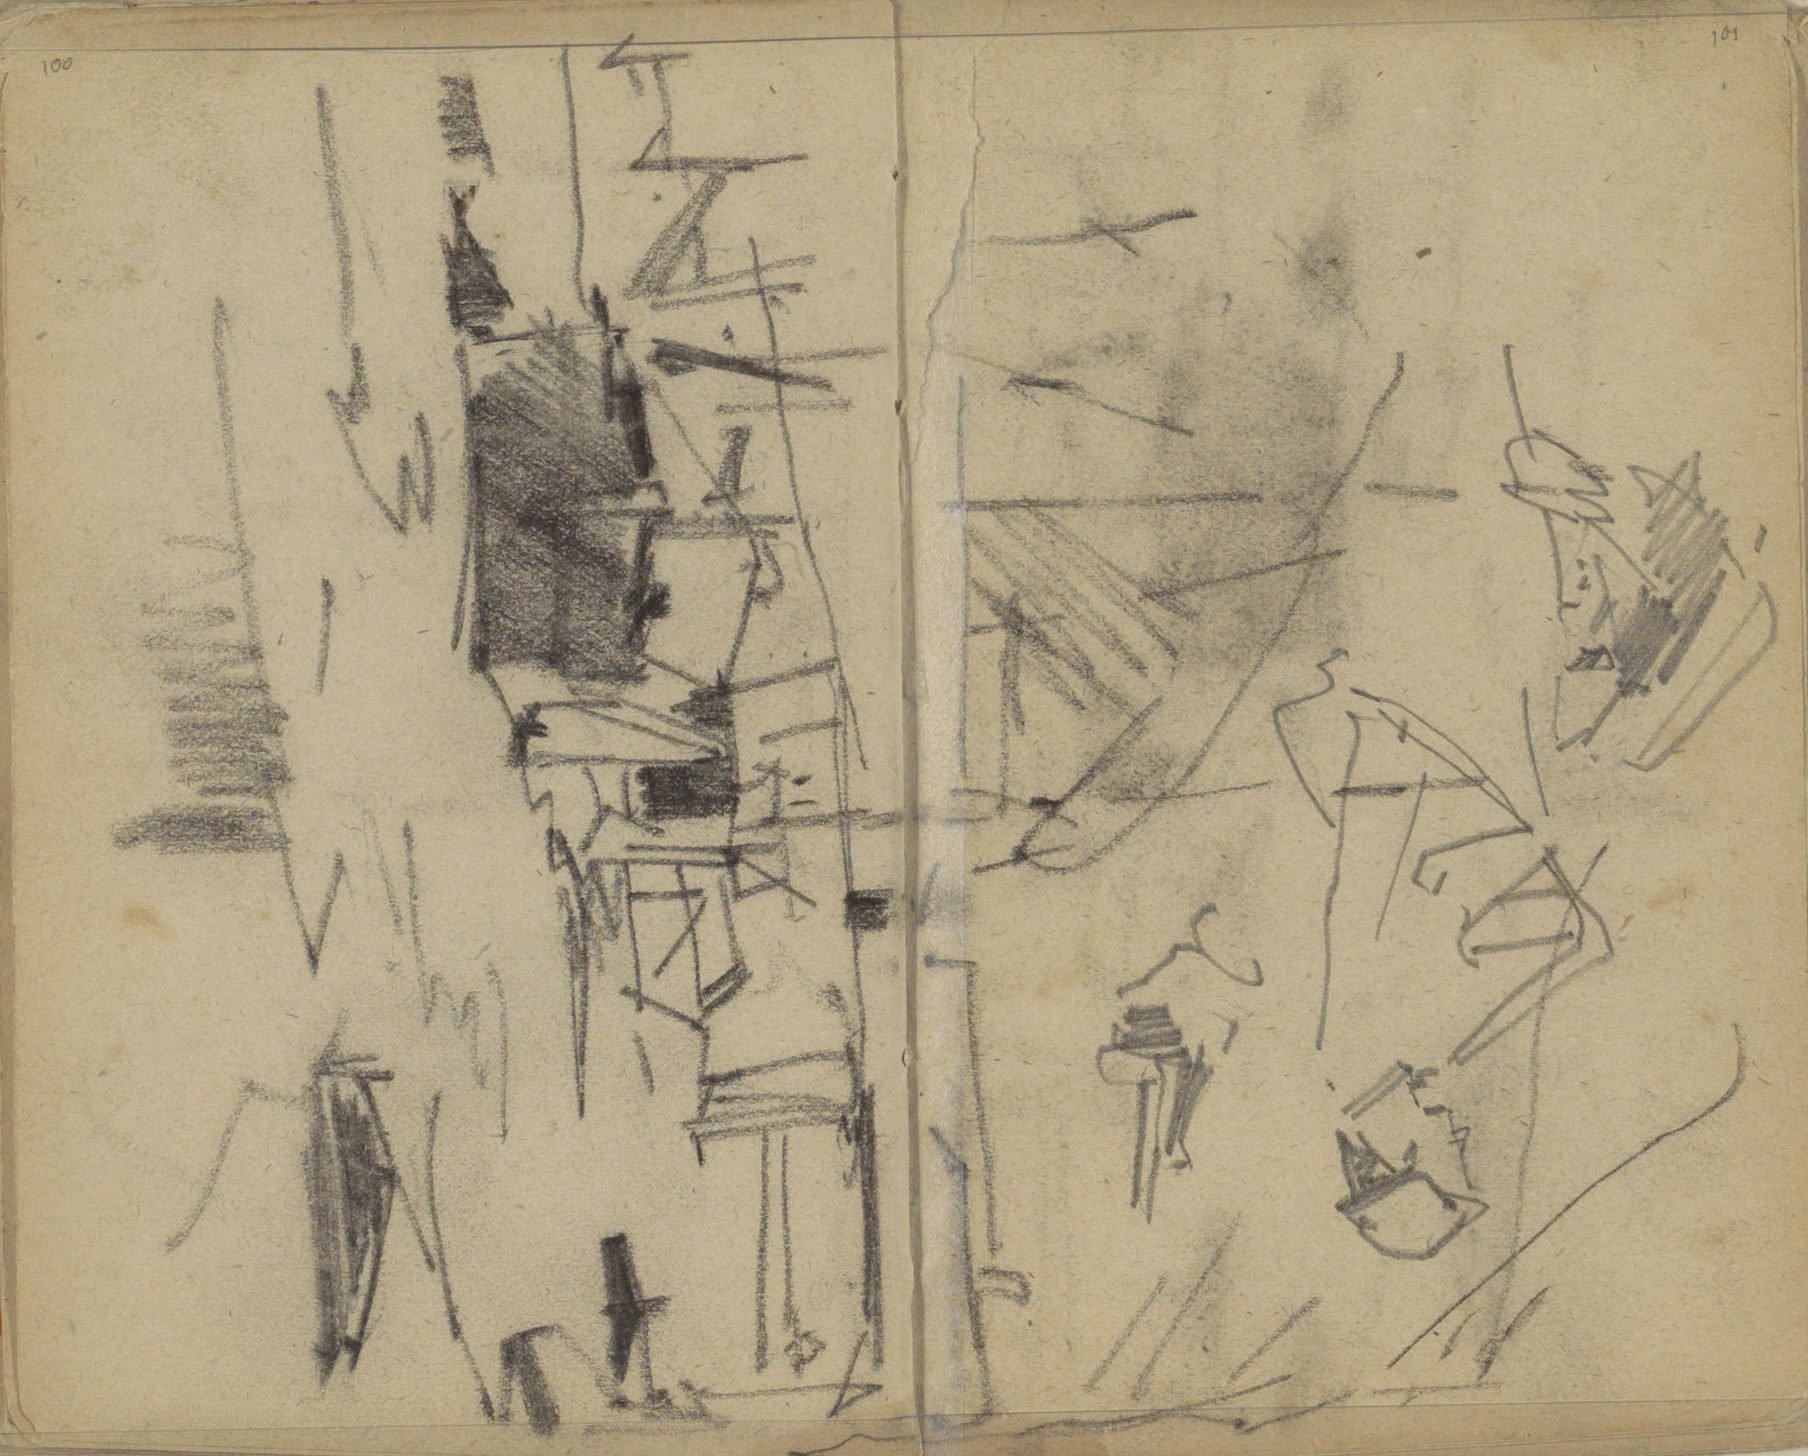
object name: sketchbook leaf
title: Studie, mogelijk van bouwmateriaal bij een schuur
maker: george hendrik breitner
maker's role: draughtsman, painter, print maker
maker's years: 1857-1923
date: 1881-1883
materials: chalk, paper, pencil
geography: south holland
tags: building materials, rural housing, e.g. country-house, villa, cottage, shed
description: Studie, mogelijk van bouwmateriaal bij een schuur. Pagina 100 en pagina 101 uit een schetsboek met 70 bladen.